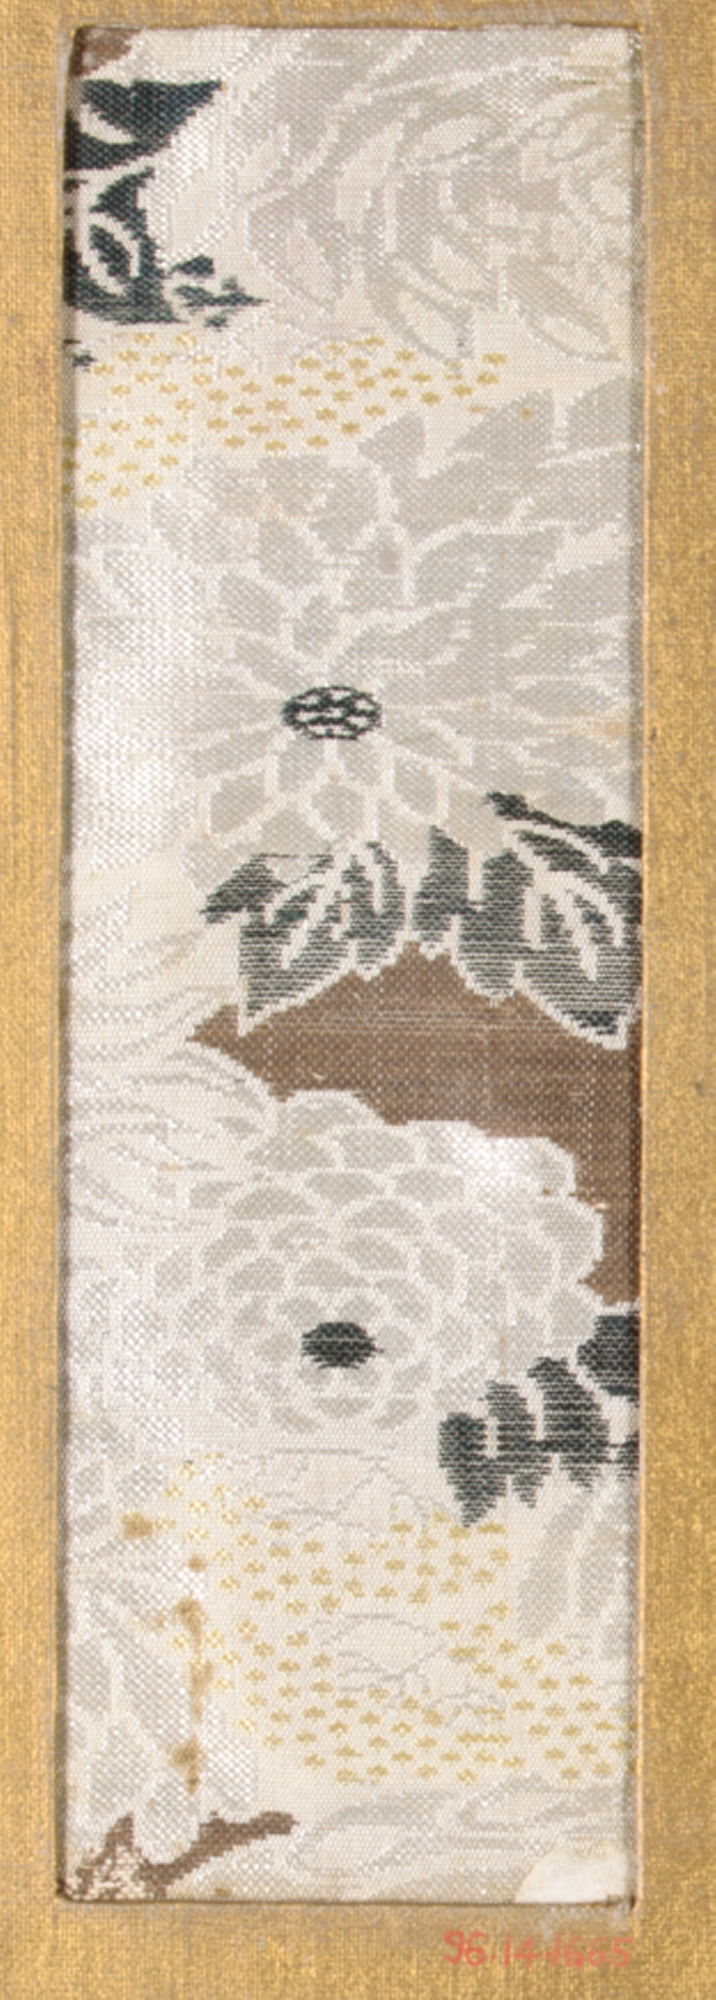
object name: piece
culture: japanese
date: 1701-1900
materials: silk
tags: leaves